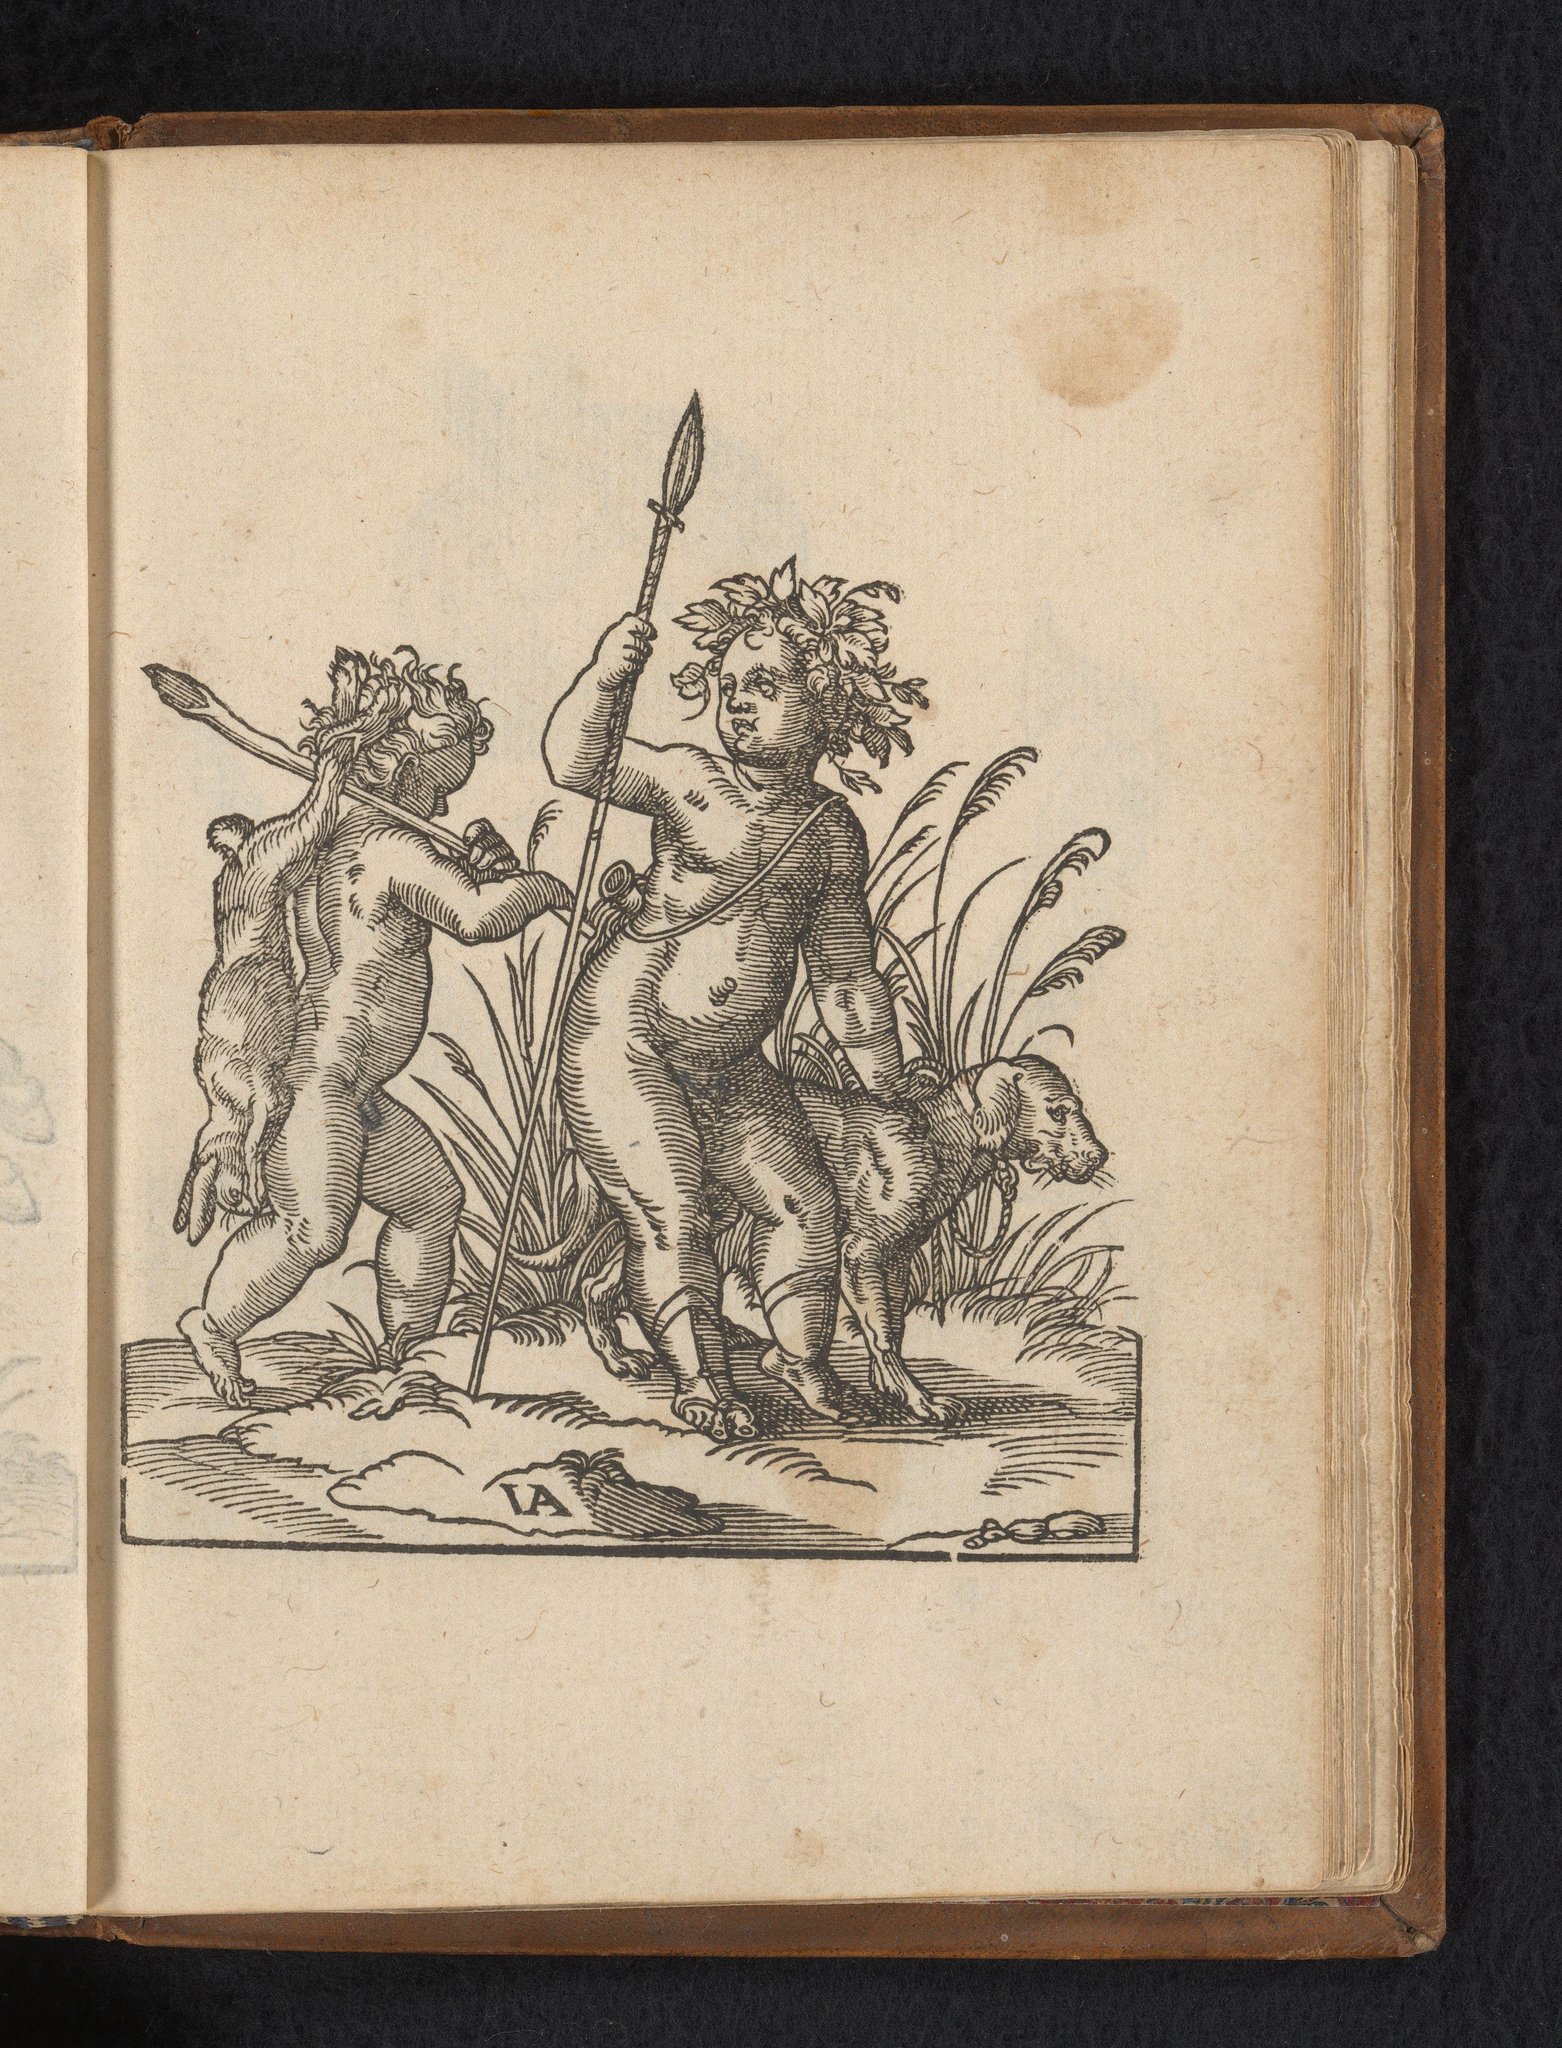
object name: print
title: Twee kinderen als jagers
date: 1578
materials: paper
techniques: woodcut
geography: nuremberg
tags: hunting dogs, hunter, children behaving like adults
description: Twee naakte kinderen als jagers, één met een gevangen haas, de ander met een jachthond. Onderdeel van het modelboek Enchiridion artis pingendi, fingendi & sculpendi met 108 figuren bedoeld voor beginnende schilders, beeldhouwers en prentmakers.